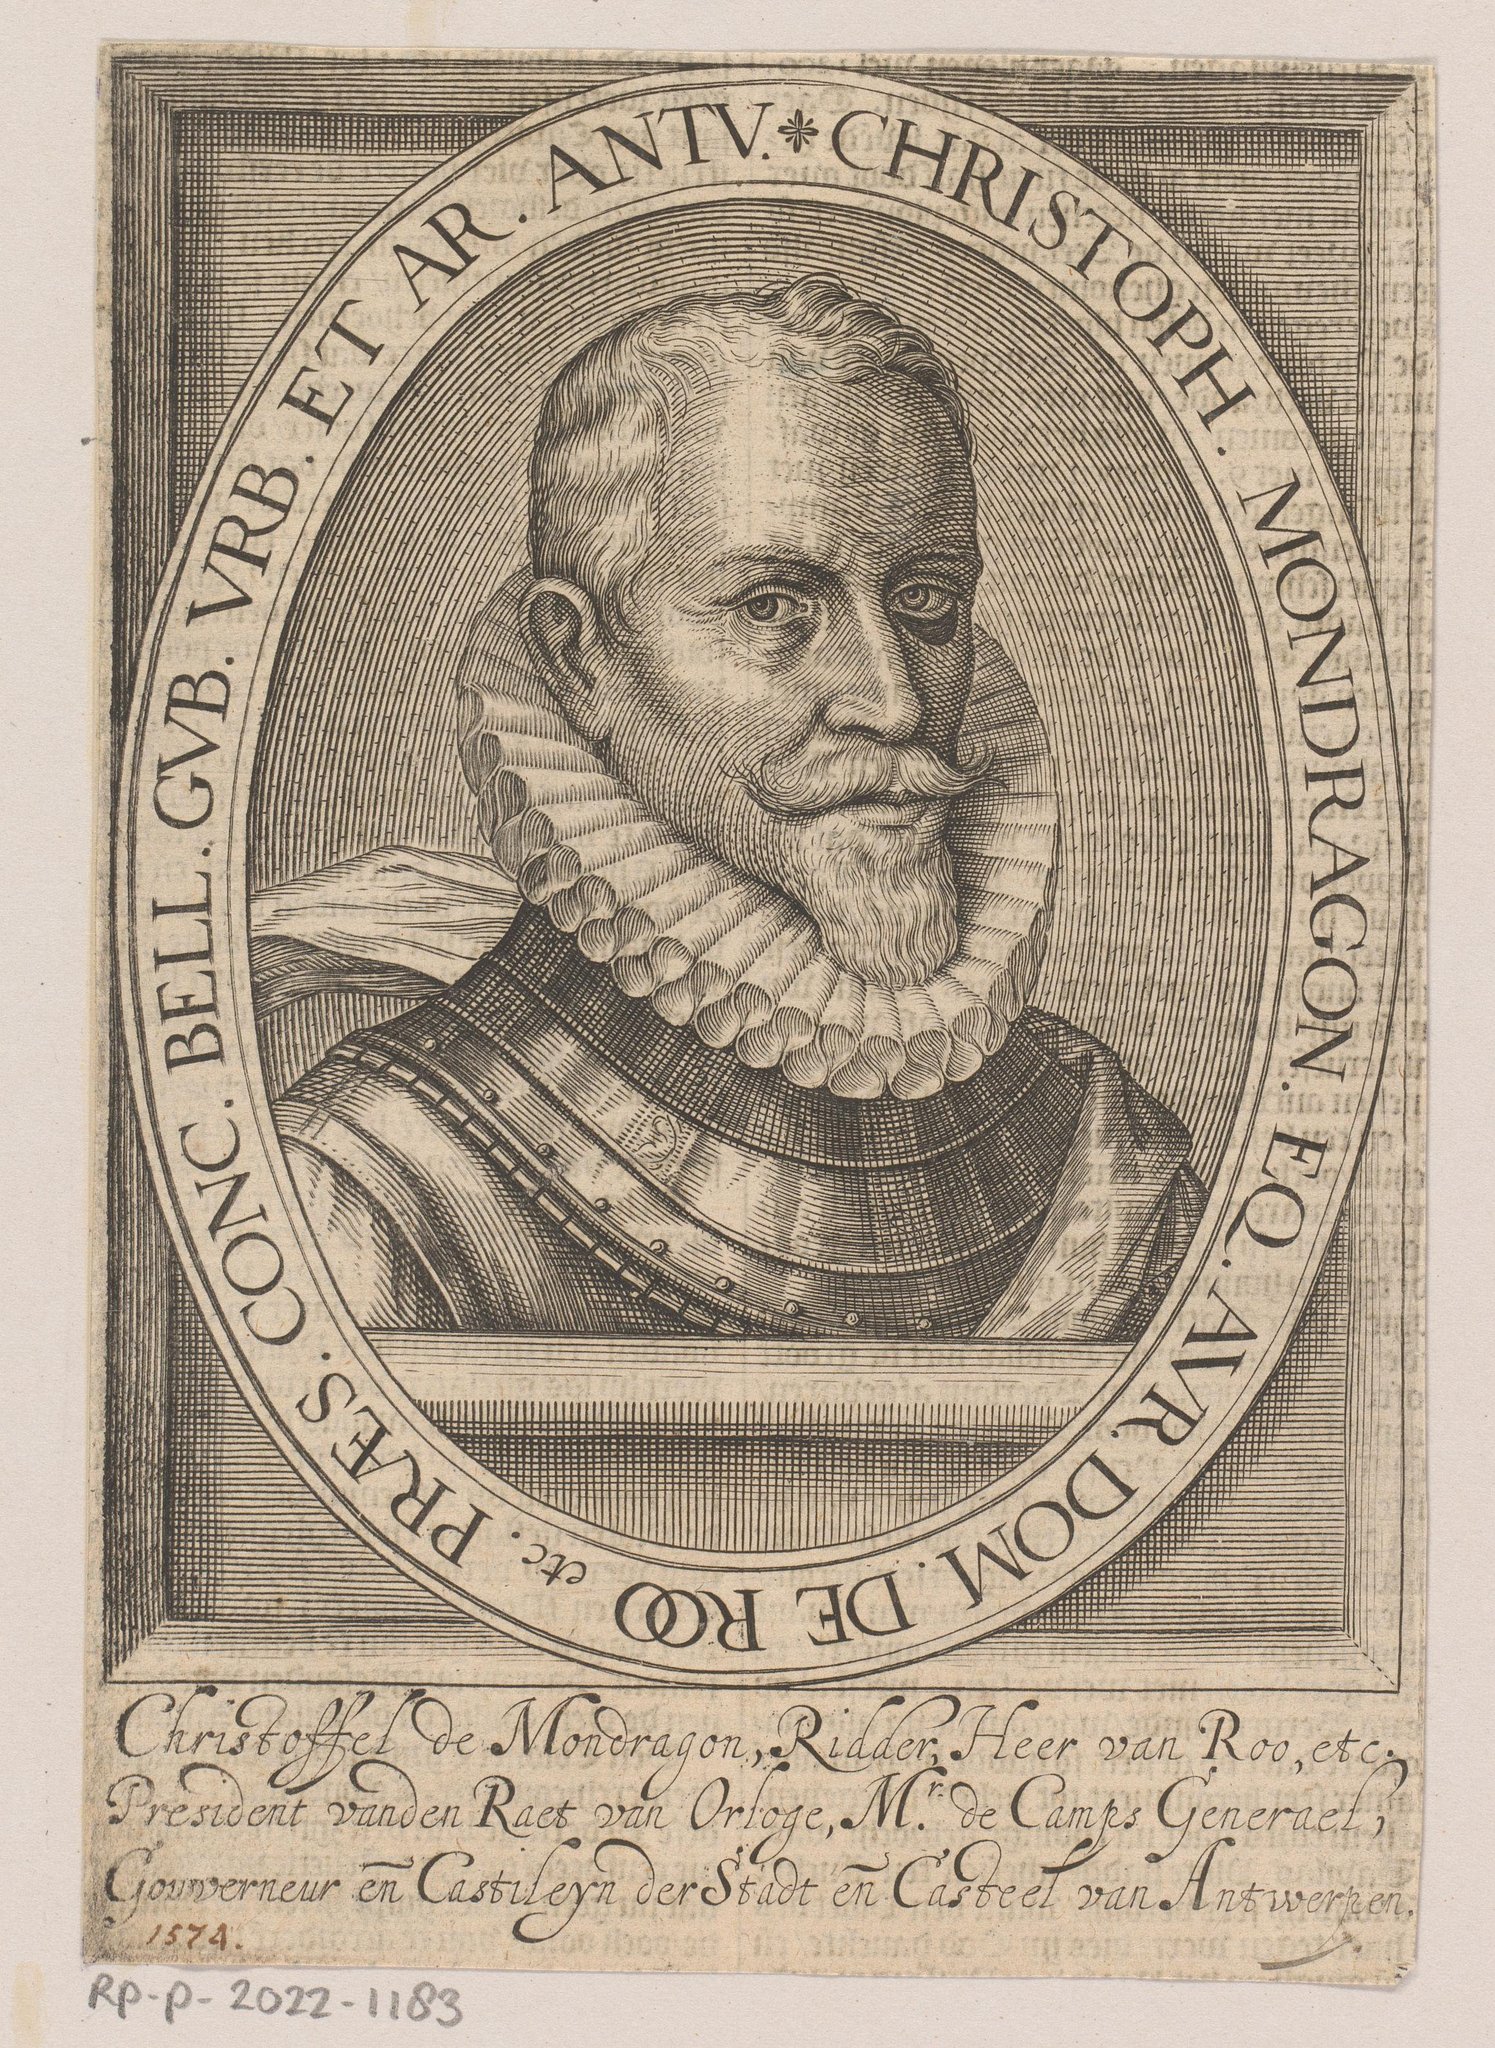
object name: print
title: Christoph. Mondragon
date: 1614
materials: paper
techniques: engraving, letterpress printing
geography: the hague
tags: armour, historical persons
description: Prent uit: Meteren, Emanuel van. Historie der Neder-landscher ende haerder na-buren oorlogen ende geschiedenissen. (...) Den Haag: Hillebrant Jacobsz. van Wouw, 1614, p. 98.